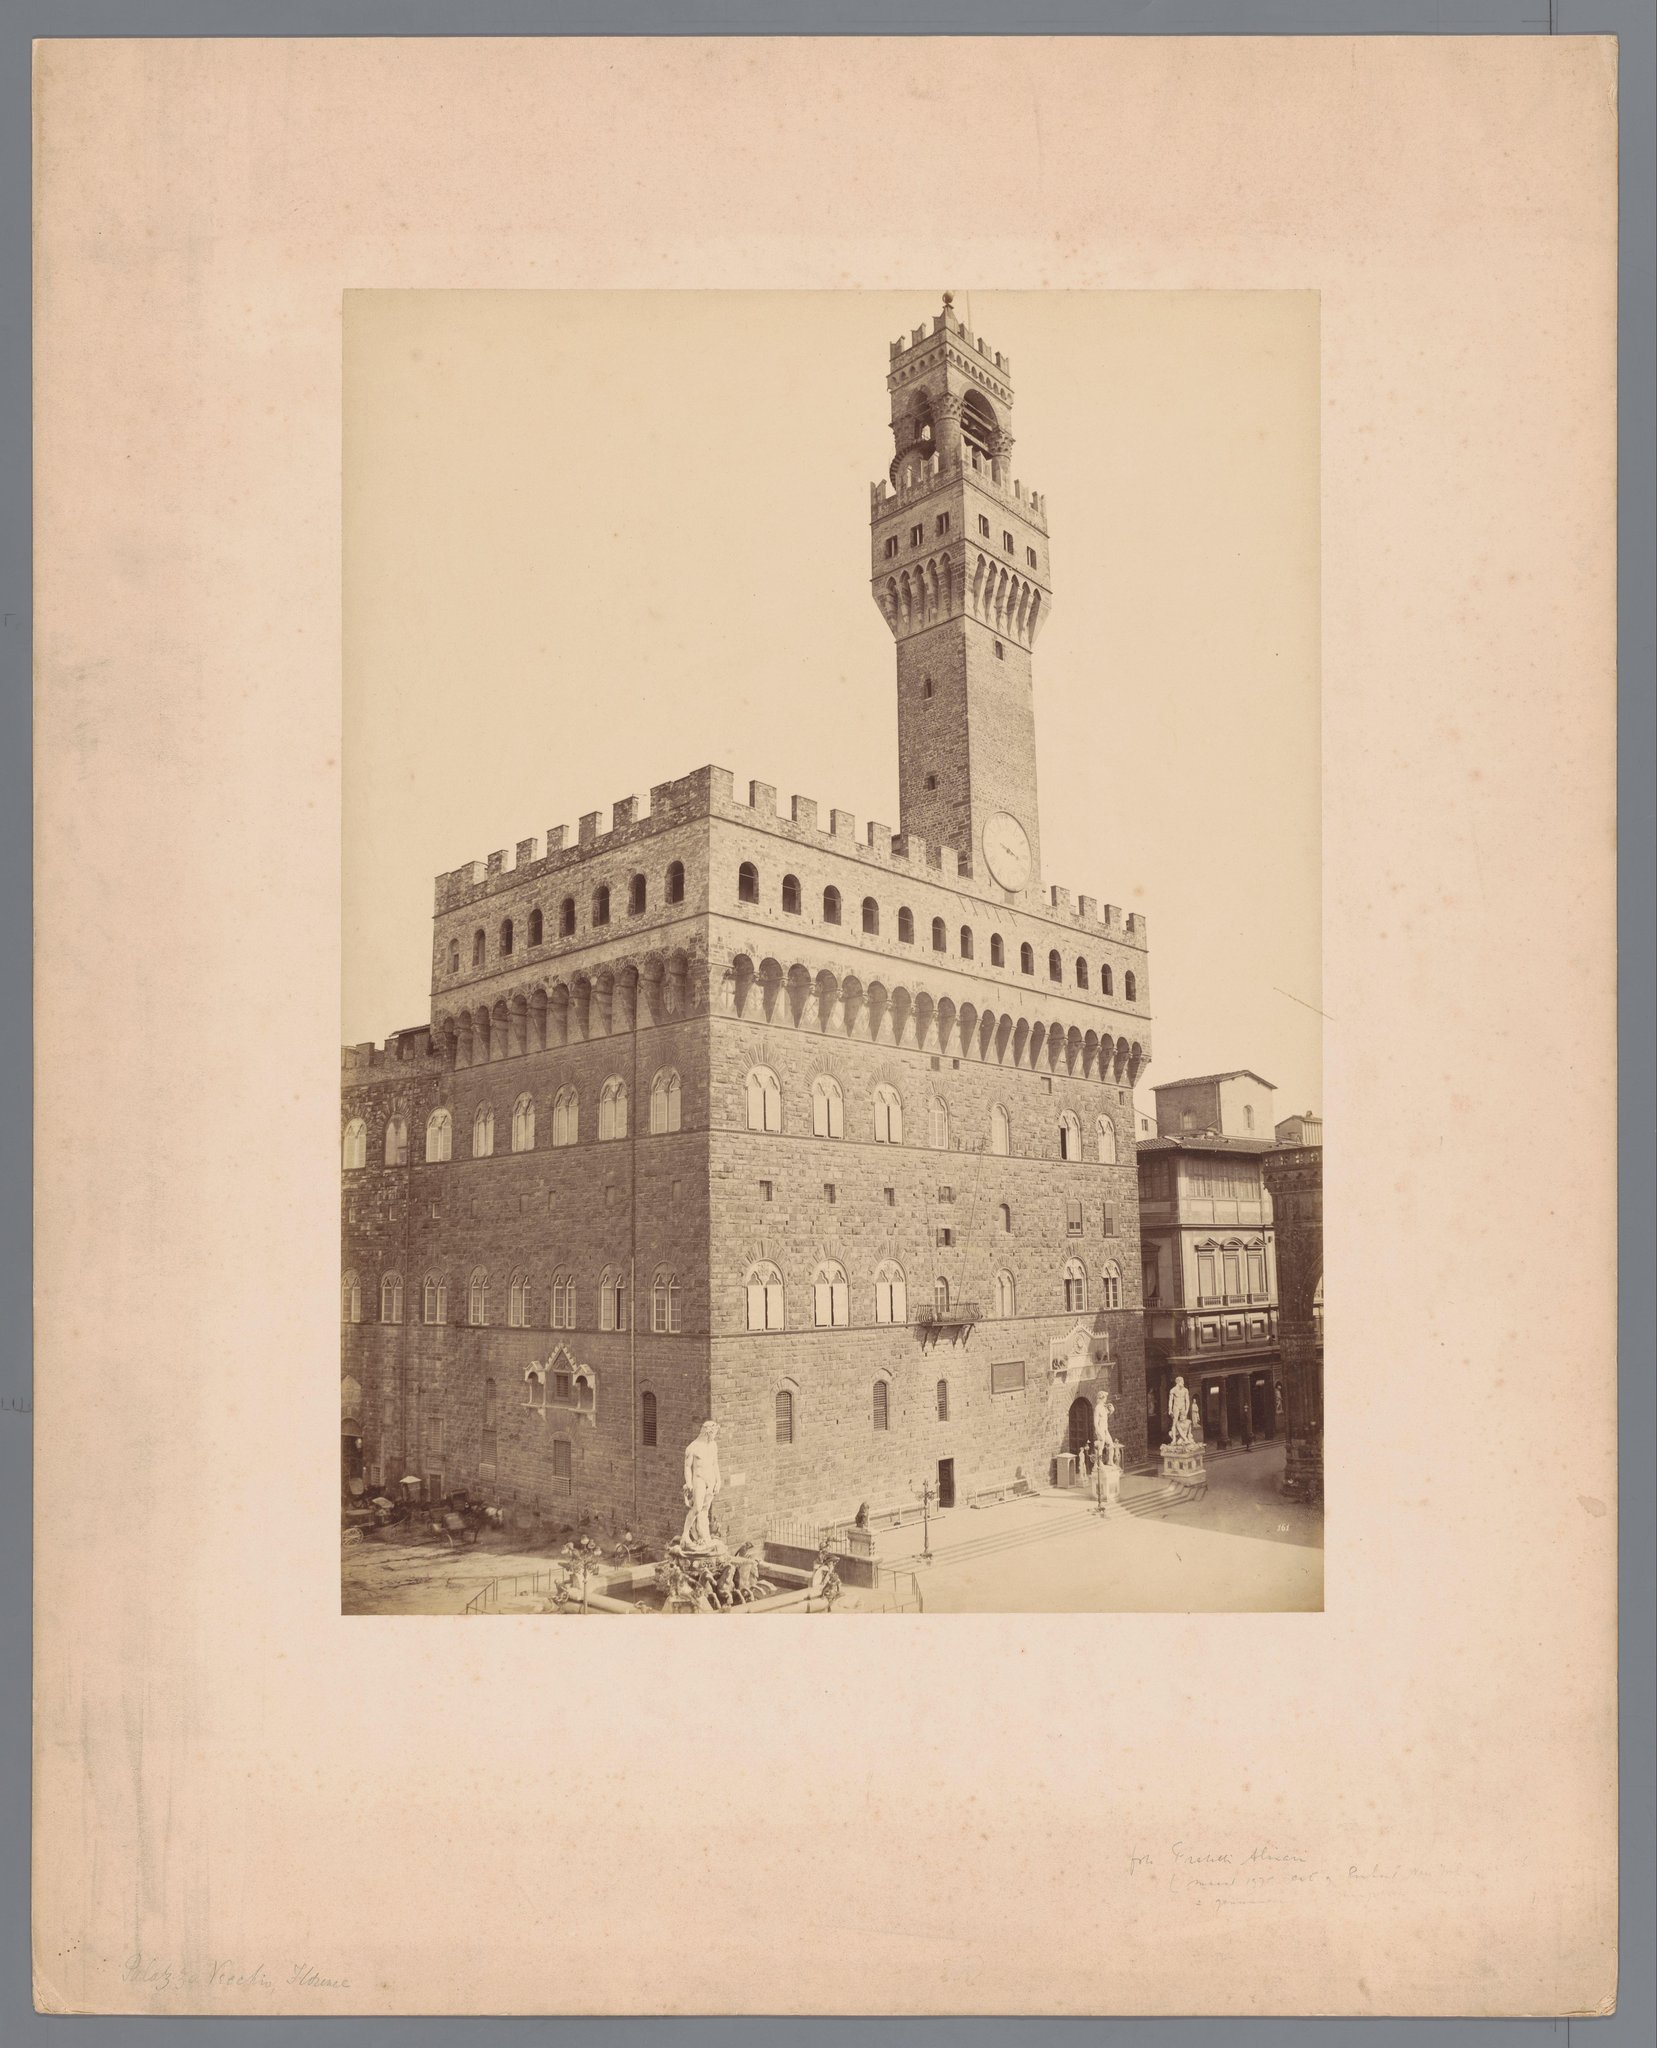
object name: photograph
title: Palazzo Vecchio, Florence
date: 1855-1870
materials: cardboard, paper, photographic support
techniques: albumen print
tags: palazzo vecchio